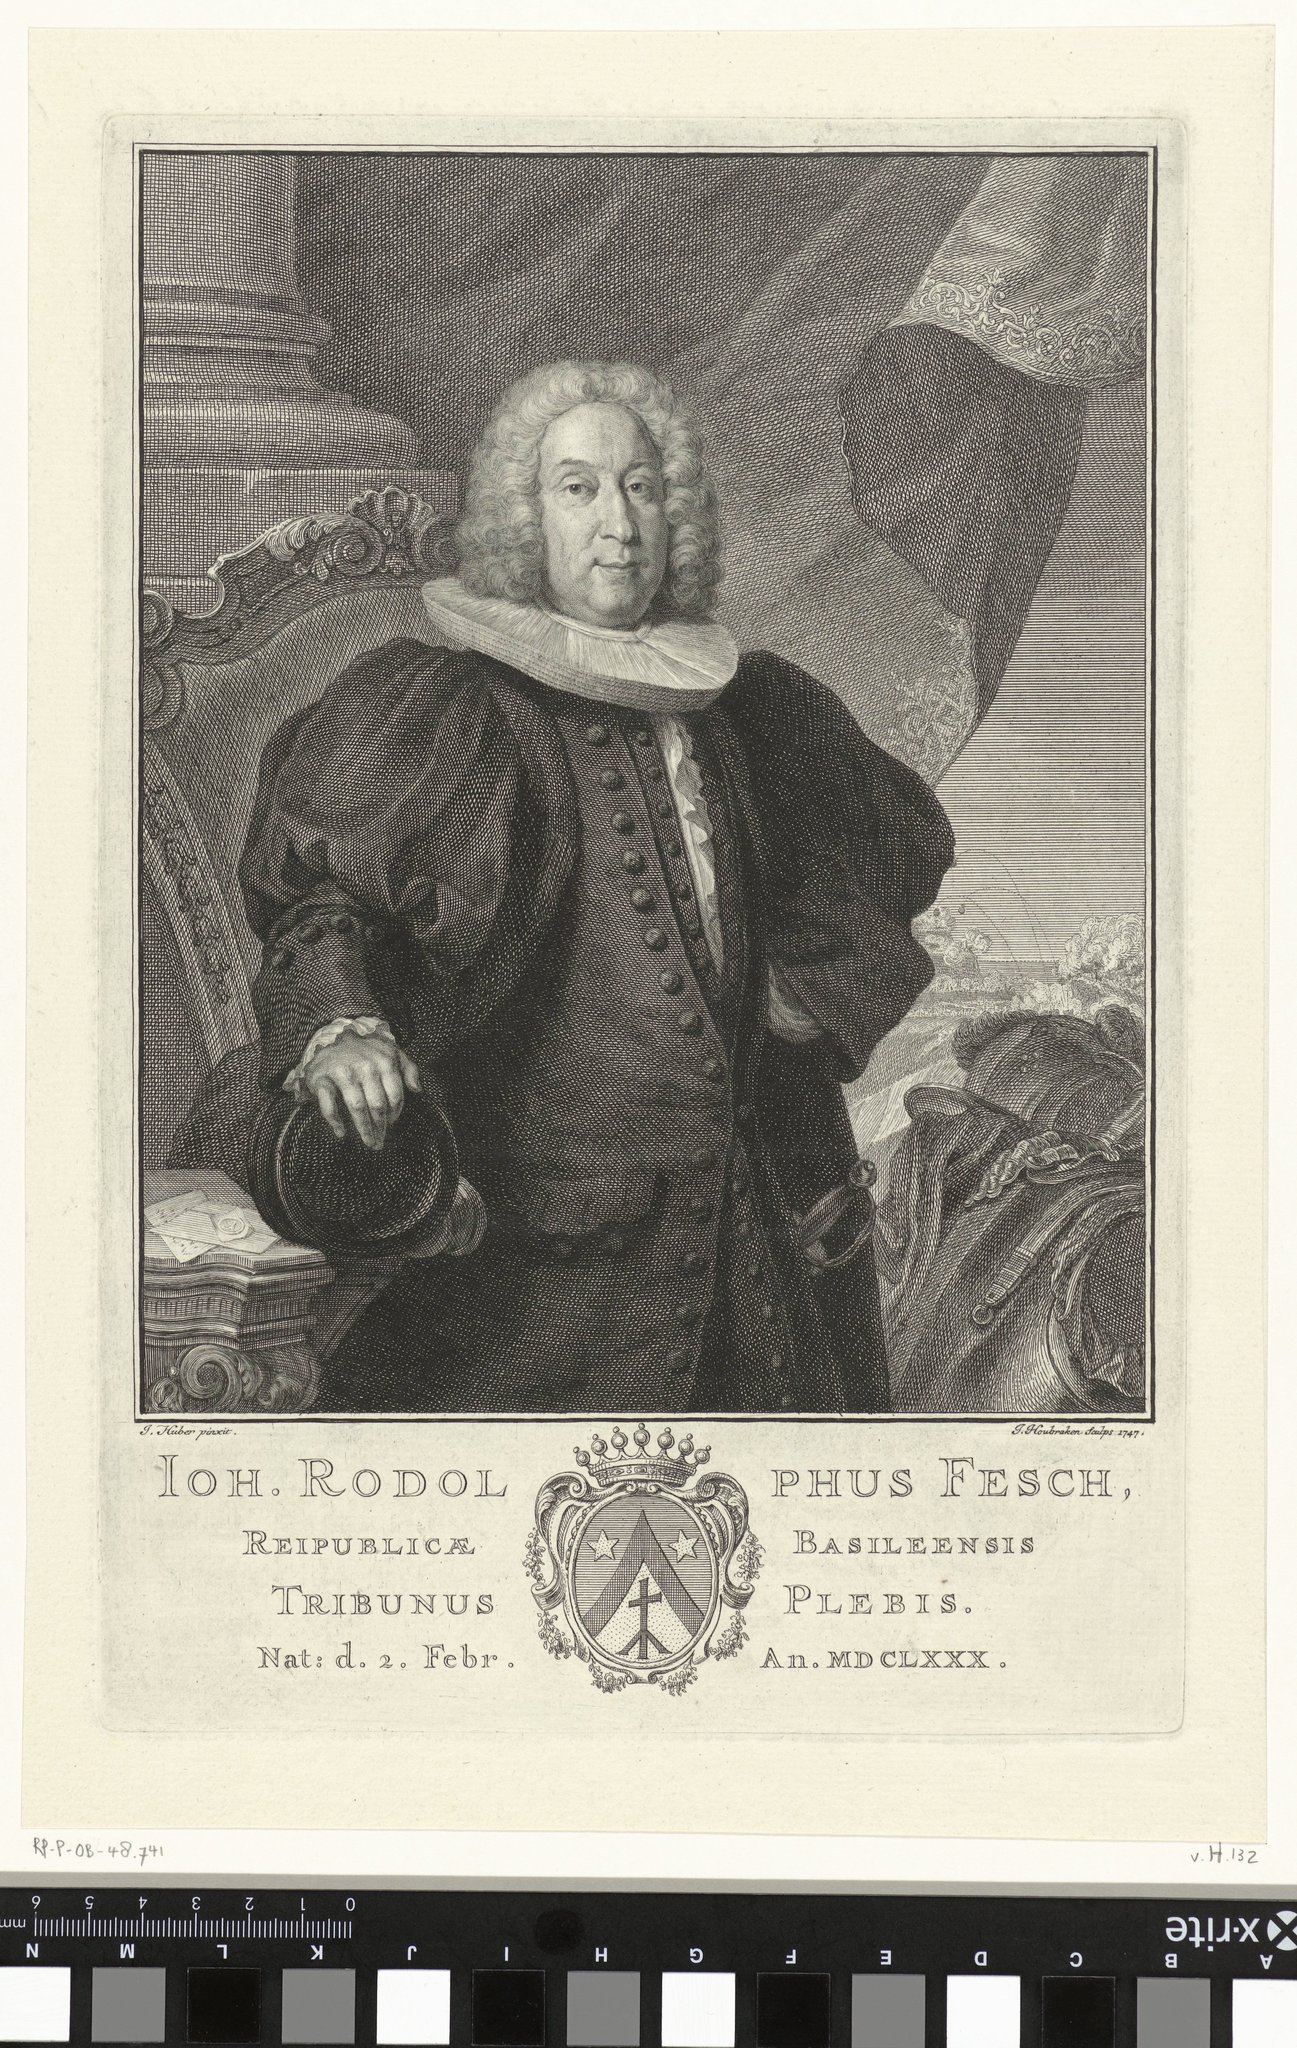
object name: print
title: Portret van Joh. Rodolphus Fesch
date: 1747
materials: paper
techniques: engraving, etching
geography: amsterdam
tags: mayor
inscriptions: collector's mark: Lugt 240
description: Kniestuk van Joh. Rodolphus Fesch, zijn rechterhand rustend op een hoed. Achter hem een zuil en een gordijn en in de achtergrond een zeeslag. Onder het portret zijn wapen en zijn naam en gegevens in vier regels in het Latijn.